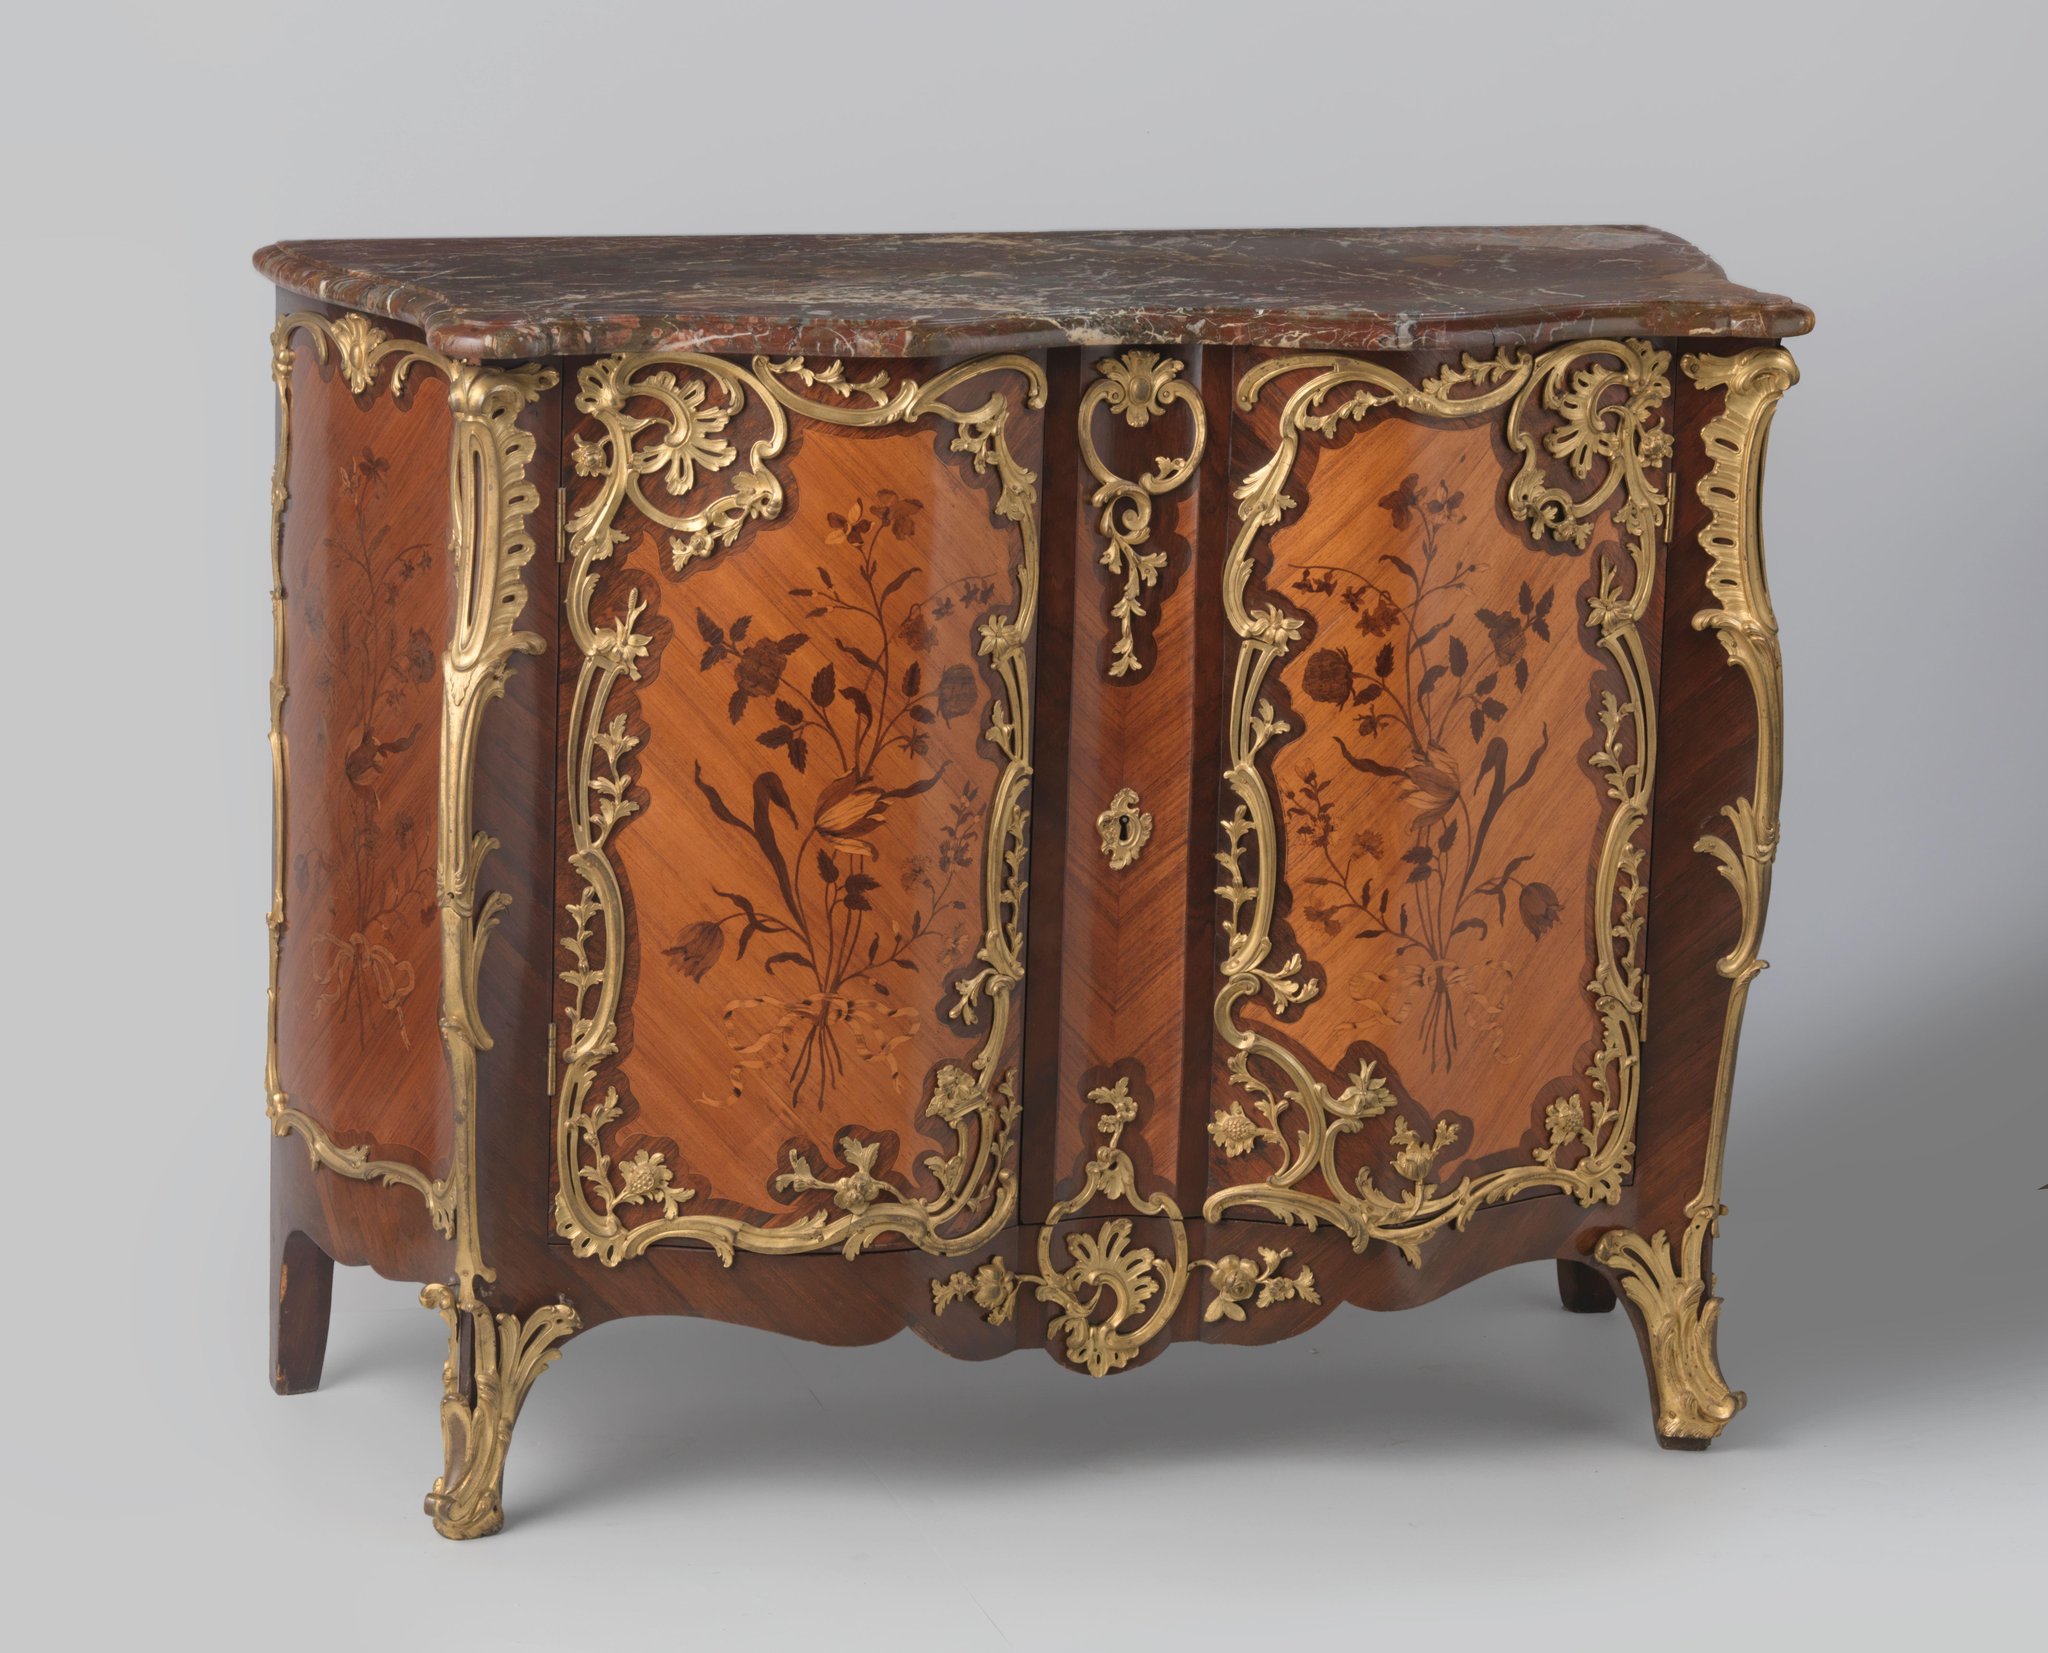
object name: case furniture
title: Kast, laag model, versierd met marqueterie en bronzen beslag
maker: boucher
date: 1750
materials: wood, bronze, marble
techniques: gilding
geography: france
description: Kast versierd met marqueterie van palissander- en rozehout en andere houtsoorten op eikenhouten kern. De S-vormige poten zijn overhoeks geplaatst en dragen beslag. Het front bestaat uit twee gebogen deuren, waartussen een geholde middenstijl, en heeft, evenals de gewelfde zijkanten, panelen in marqueterie binnen asymmetrisch verguld bronzen beslag. De panelen zijn versierd met door een strik samengebonden boeketten. Gestempeld: BVRB JME (wellicht Boucher); eigendomsmerk onder marmeren blad. Zie: BK-16679-b.